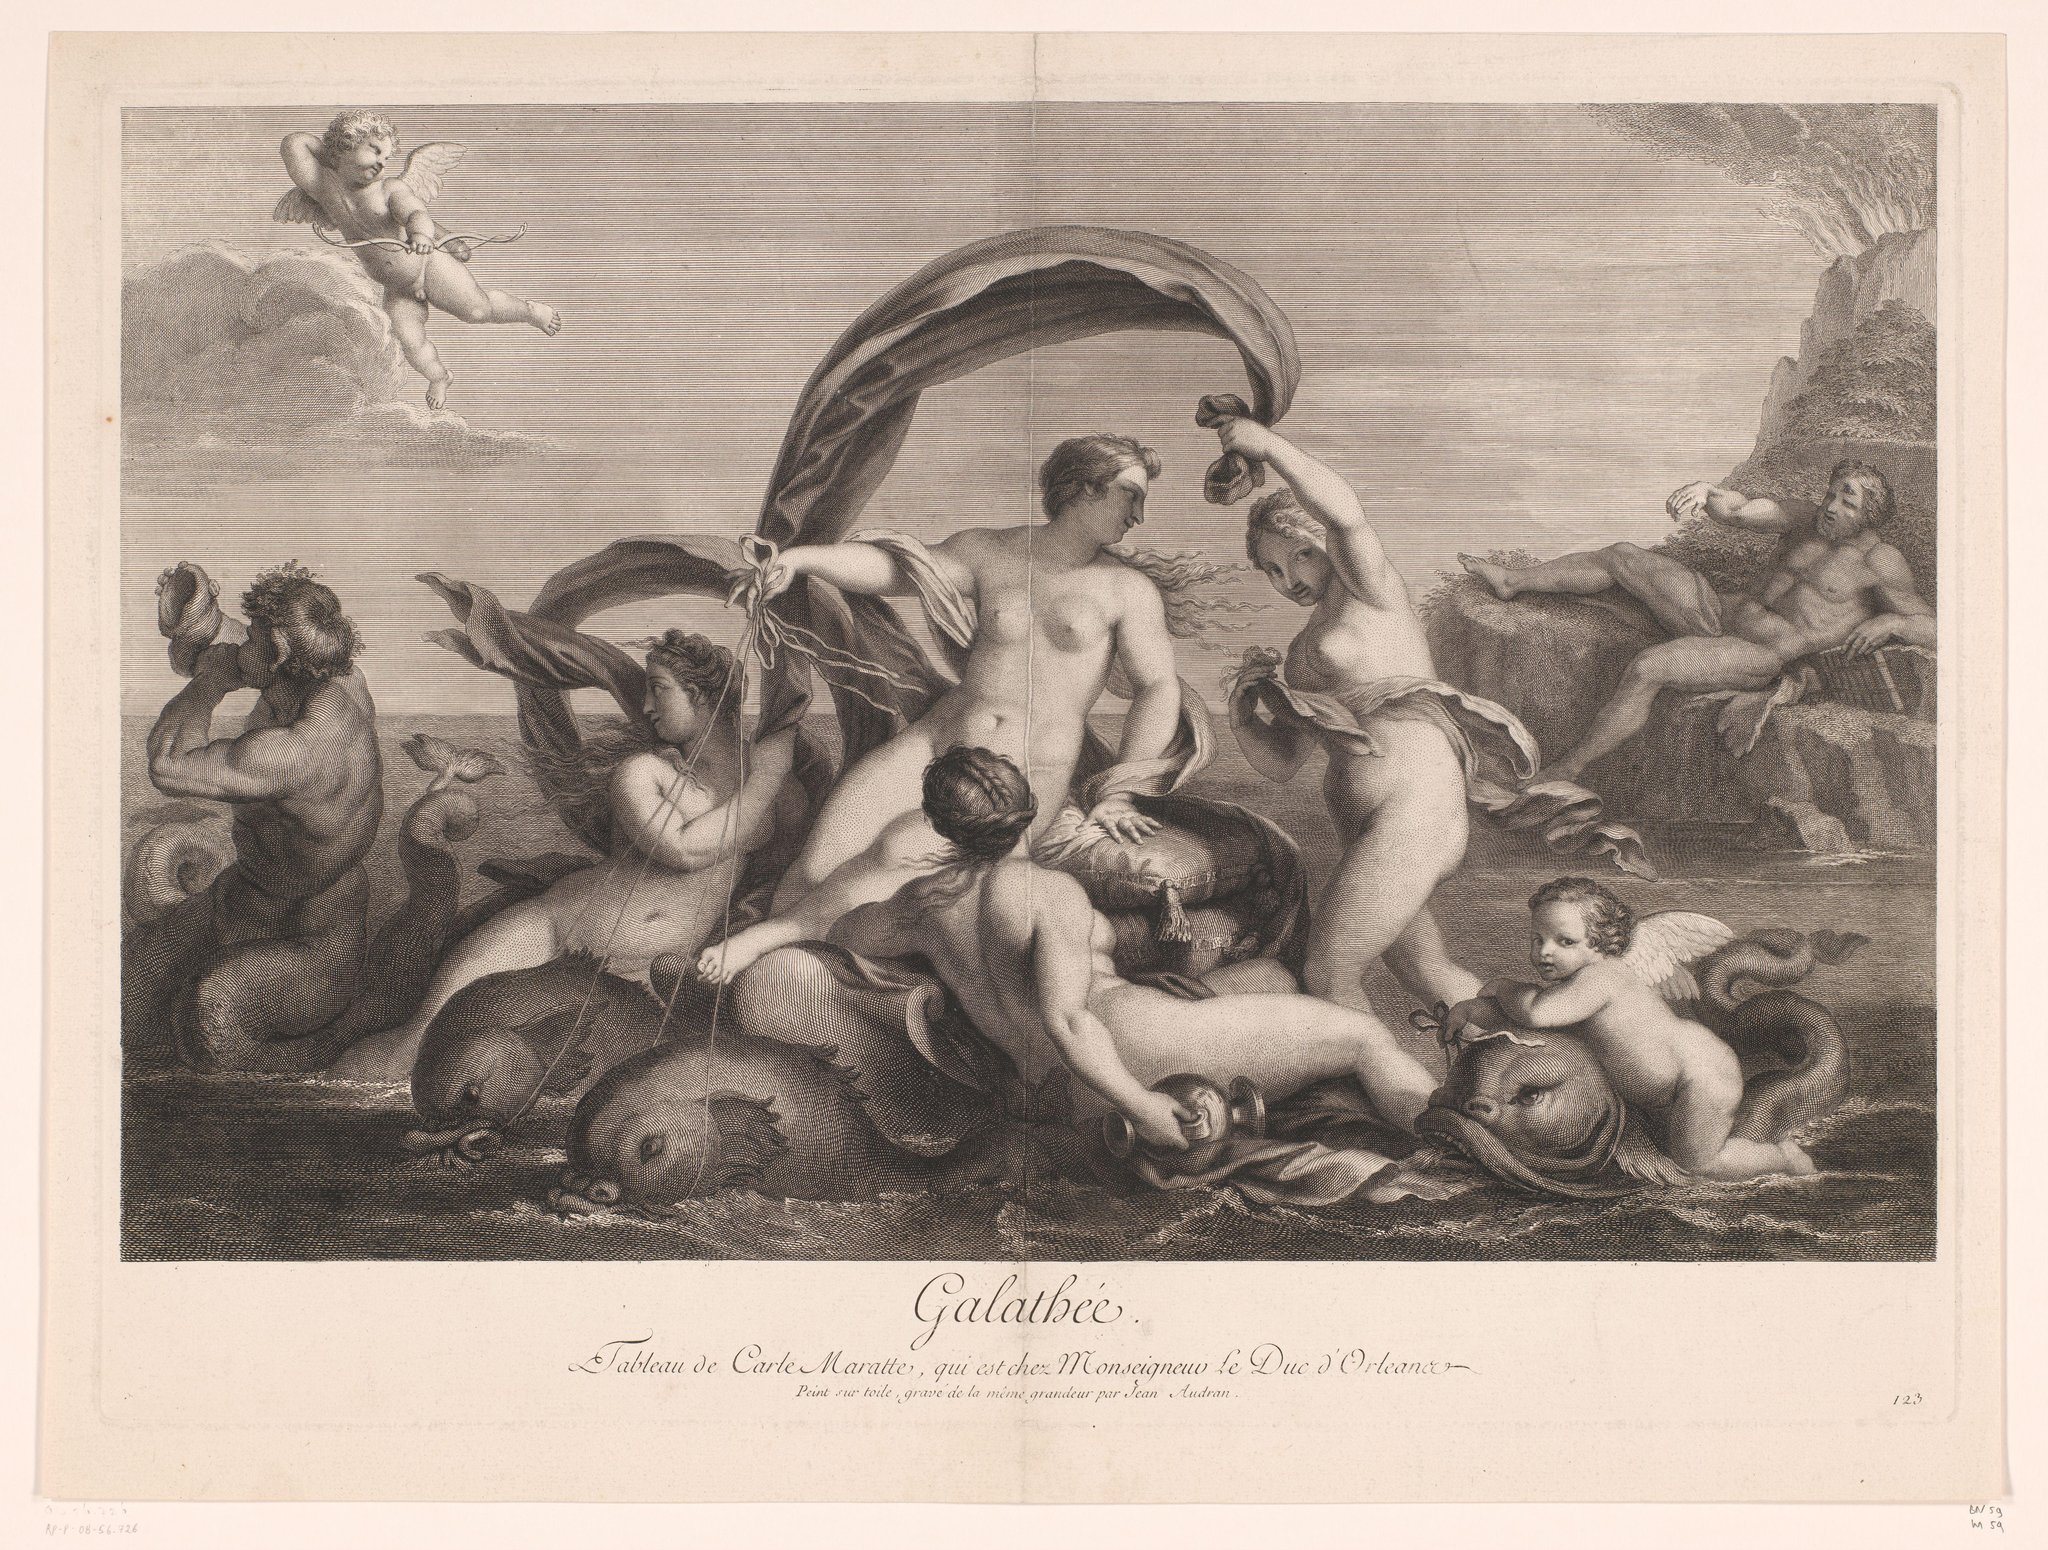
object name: print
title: Galatea gadegeslagen door Polyphemus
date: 1729-1740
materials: paper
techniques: engraving, etching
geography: france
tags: polyphemus, the cyclops, beholding acis and galatea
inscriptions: collector's mark: Lugt 240